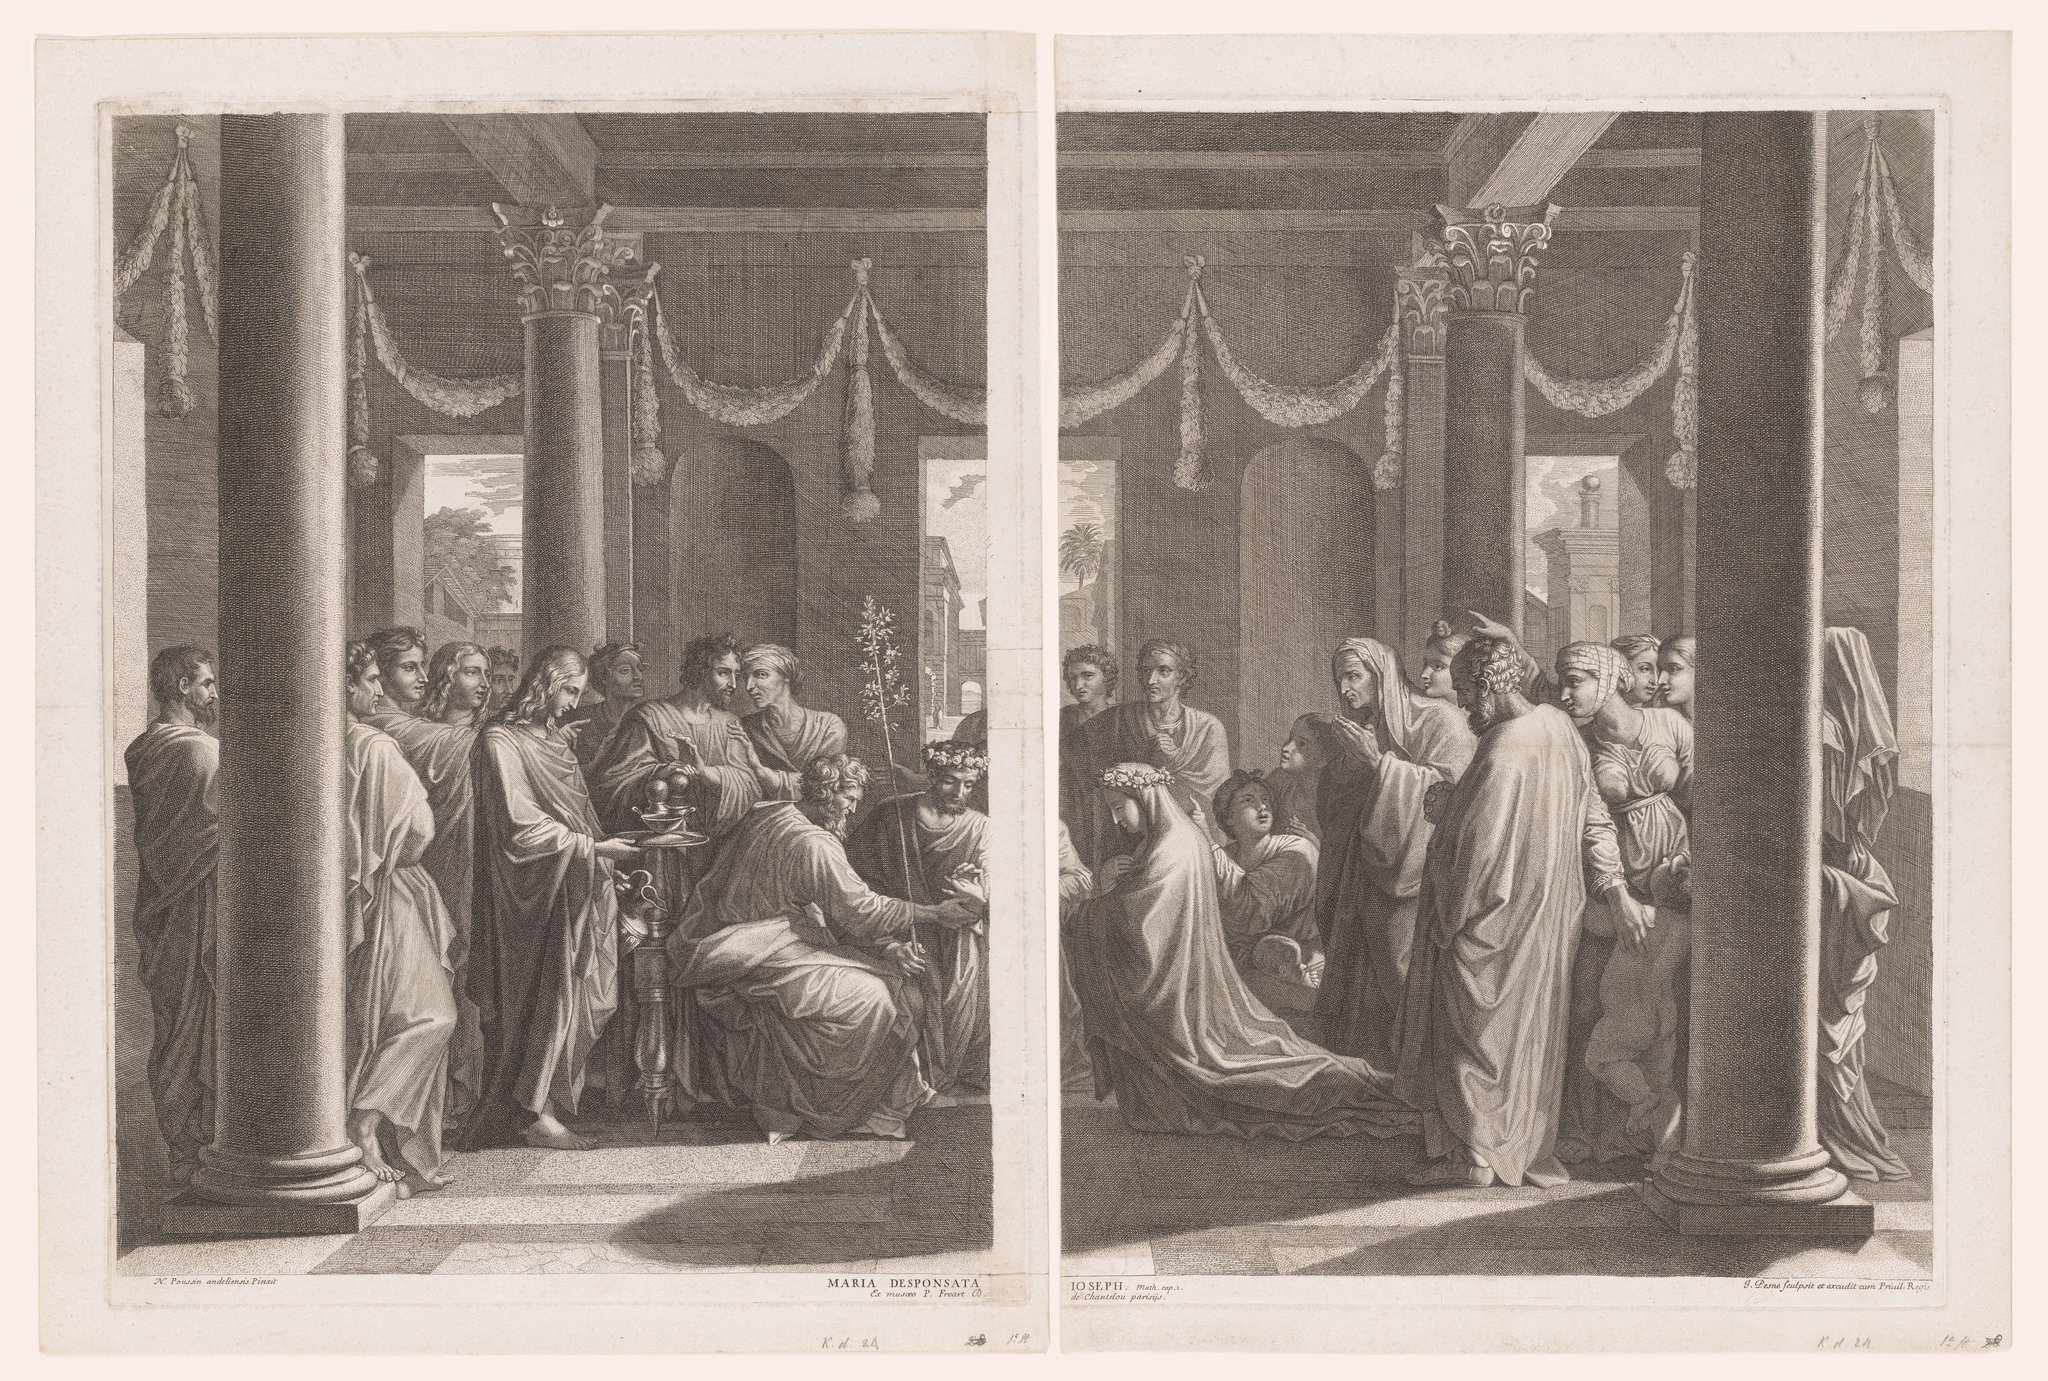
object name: print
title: Maria desponsata Ioseph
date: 1633-1700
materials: paper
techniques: etching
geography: france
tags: marriage in church ~ the sixth of the seven sacraments, marriage of mary and joseph, 'sposalizio': they are married by the high priest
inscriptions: collector's mark: Lugt 240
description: Prent maakt deel uit van een ongenummerde serie van zeven prenten. Dit object is omwille van een betere presentatie virtueel samengevoegd, maar bestaat fysiek uit losse onderdelen.